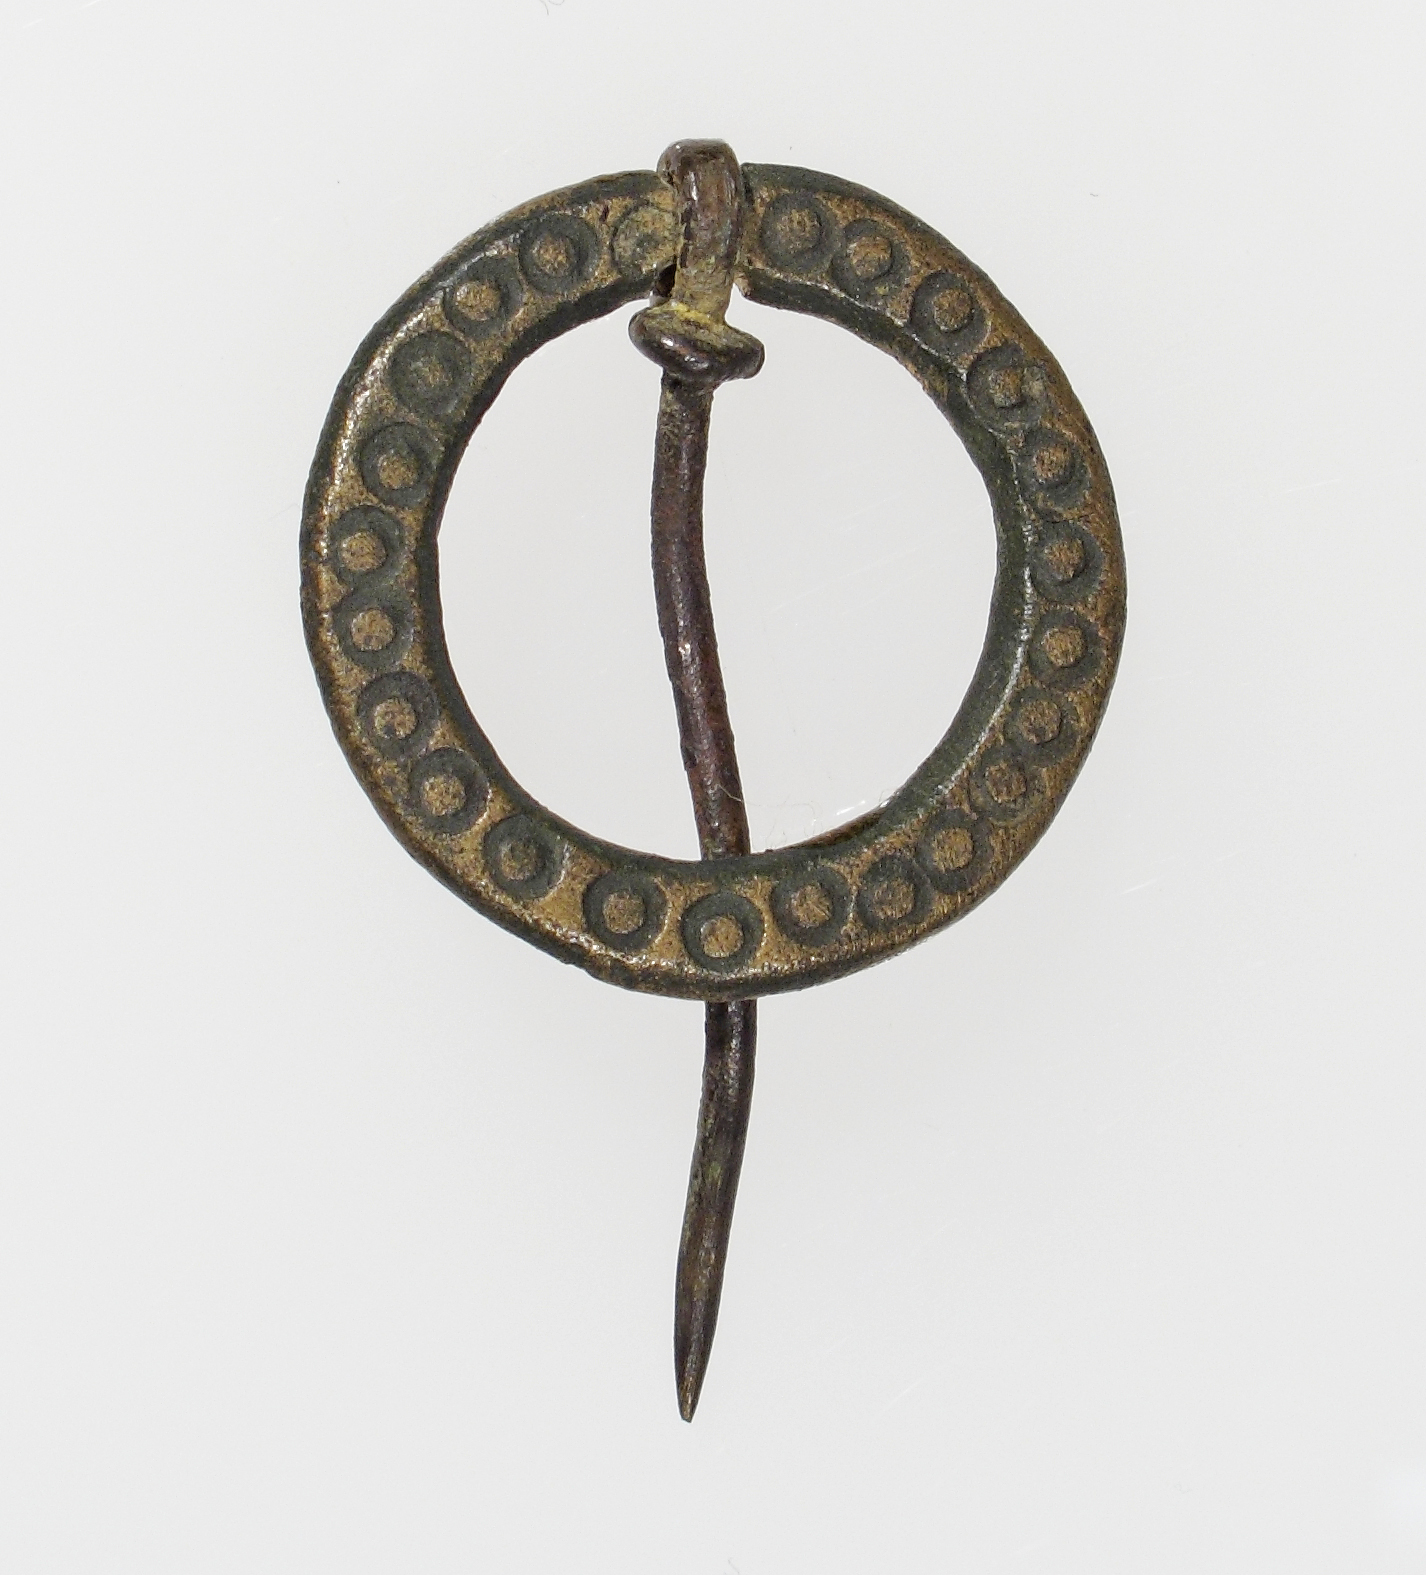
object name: ring brooch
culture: european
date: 1201-1300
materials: copper alloy